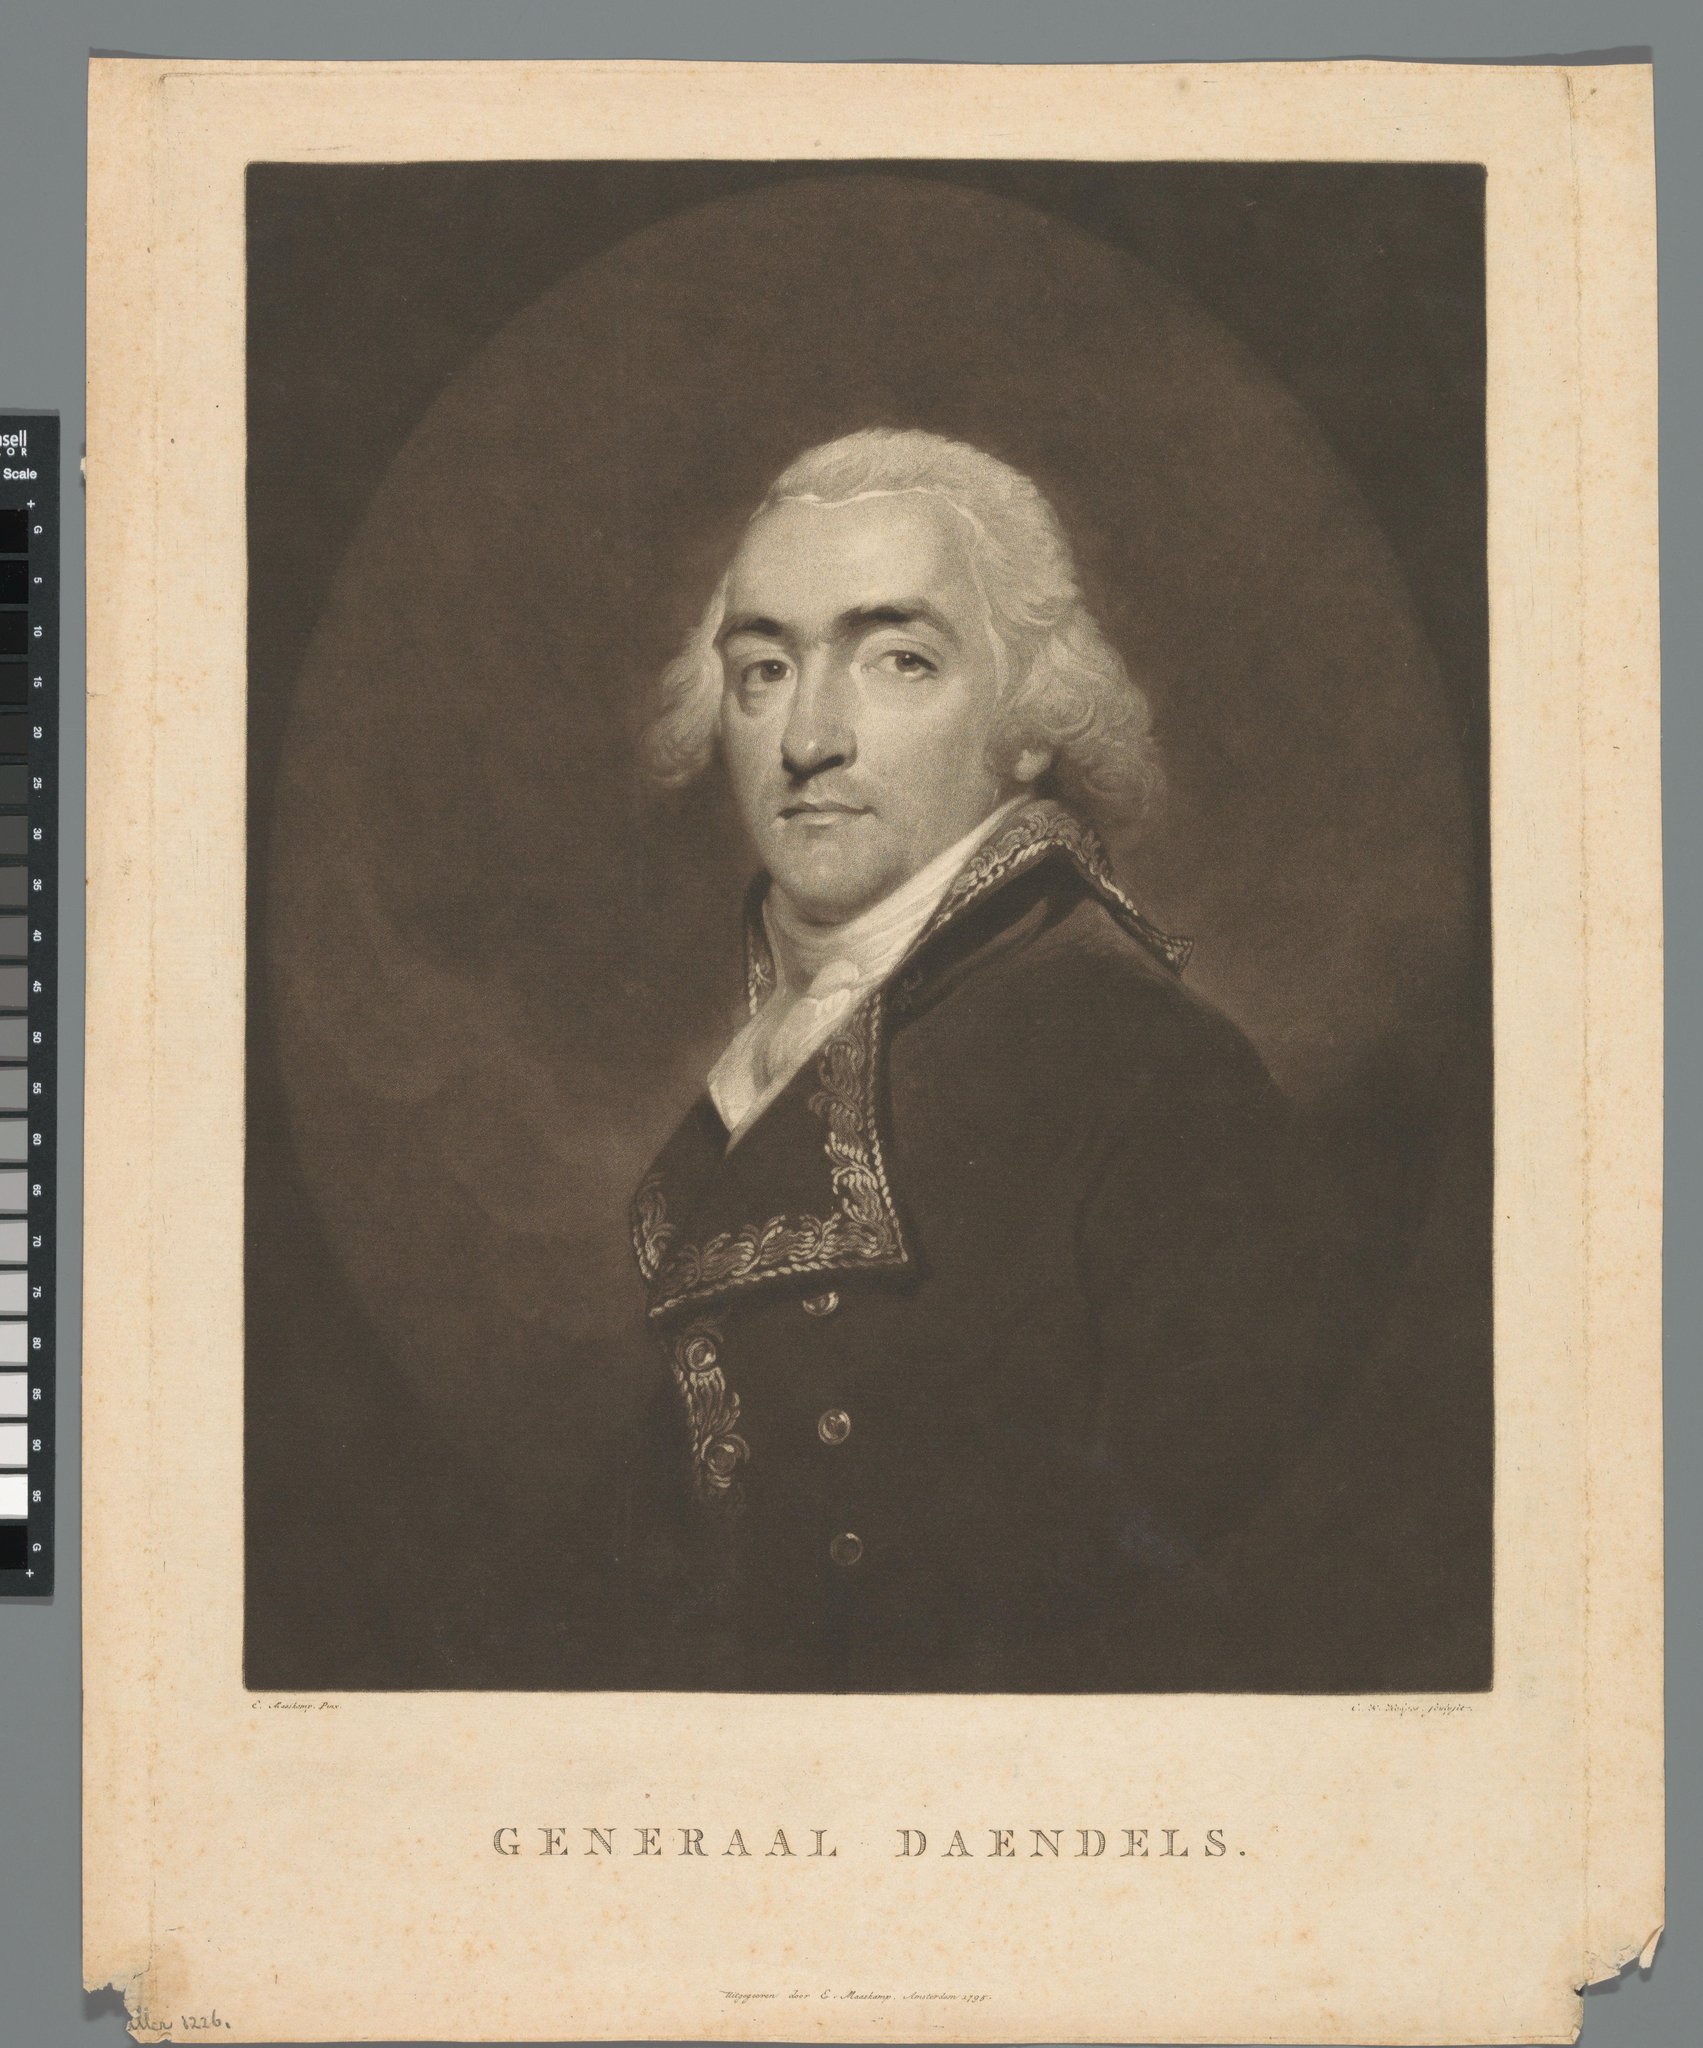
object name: print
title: Portret van Herman Willem Daendels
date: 1795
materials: paper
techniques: mezzotint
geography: the hague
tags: herman willem daendels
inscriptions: date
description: Portret van generaal Herman Willem Daendels. In de ondermarge zijn naam en titel.